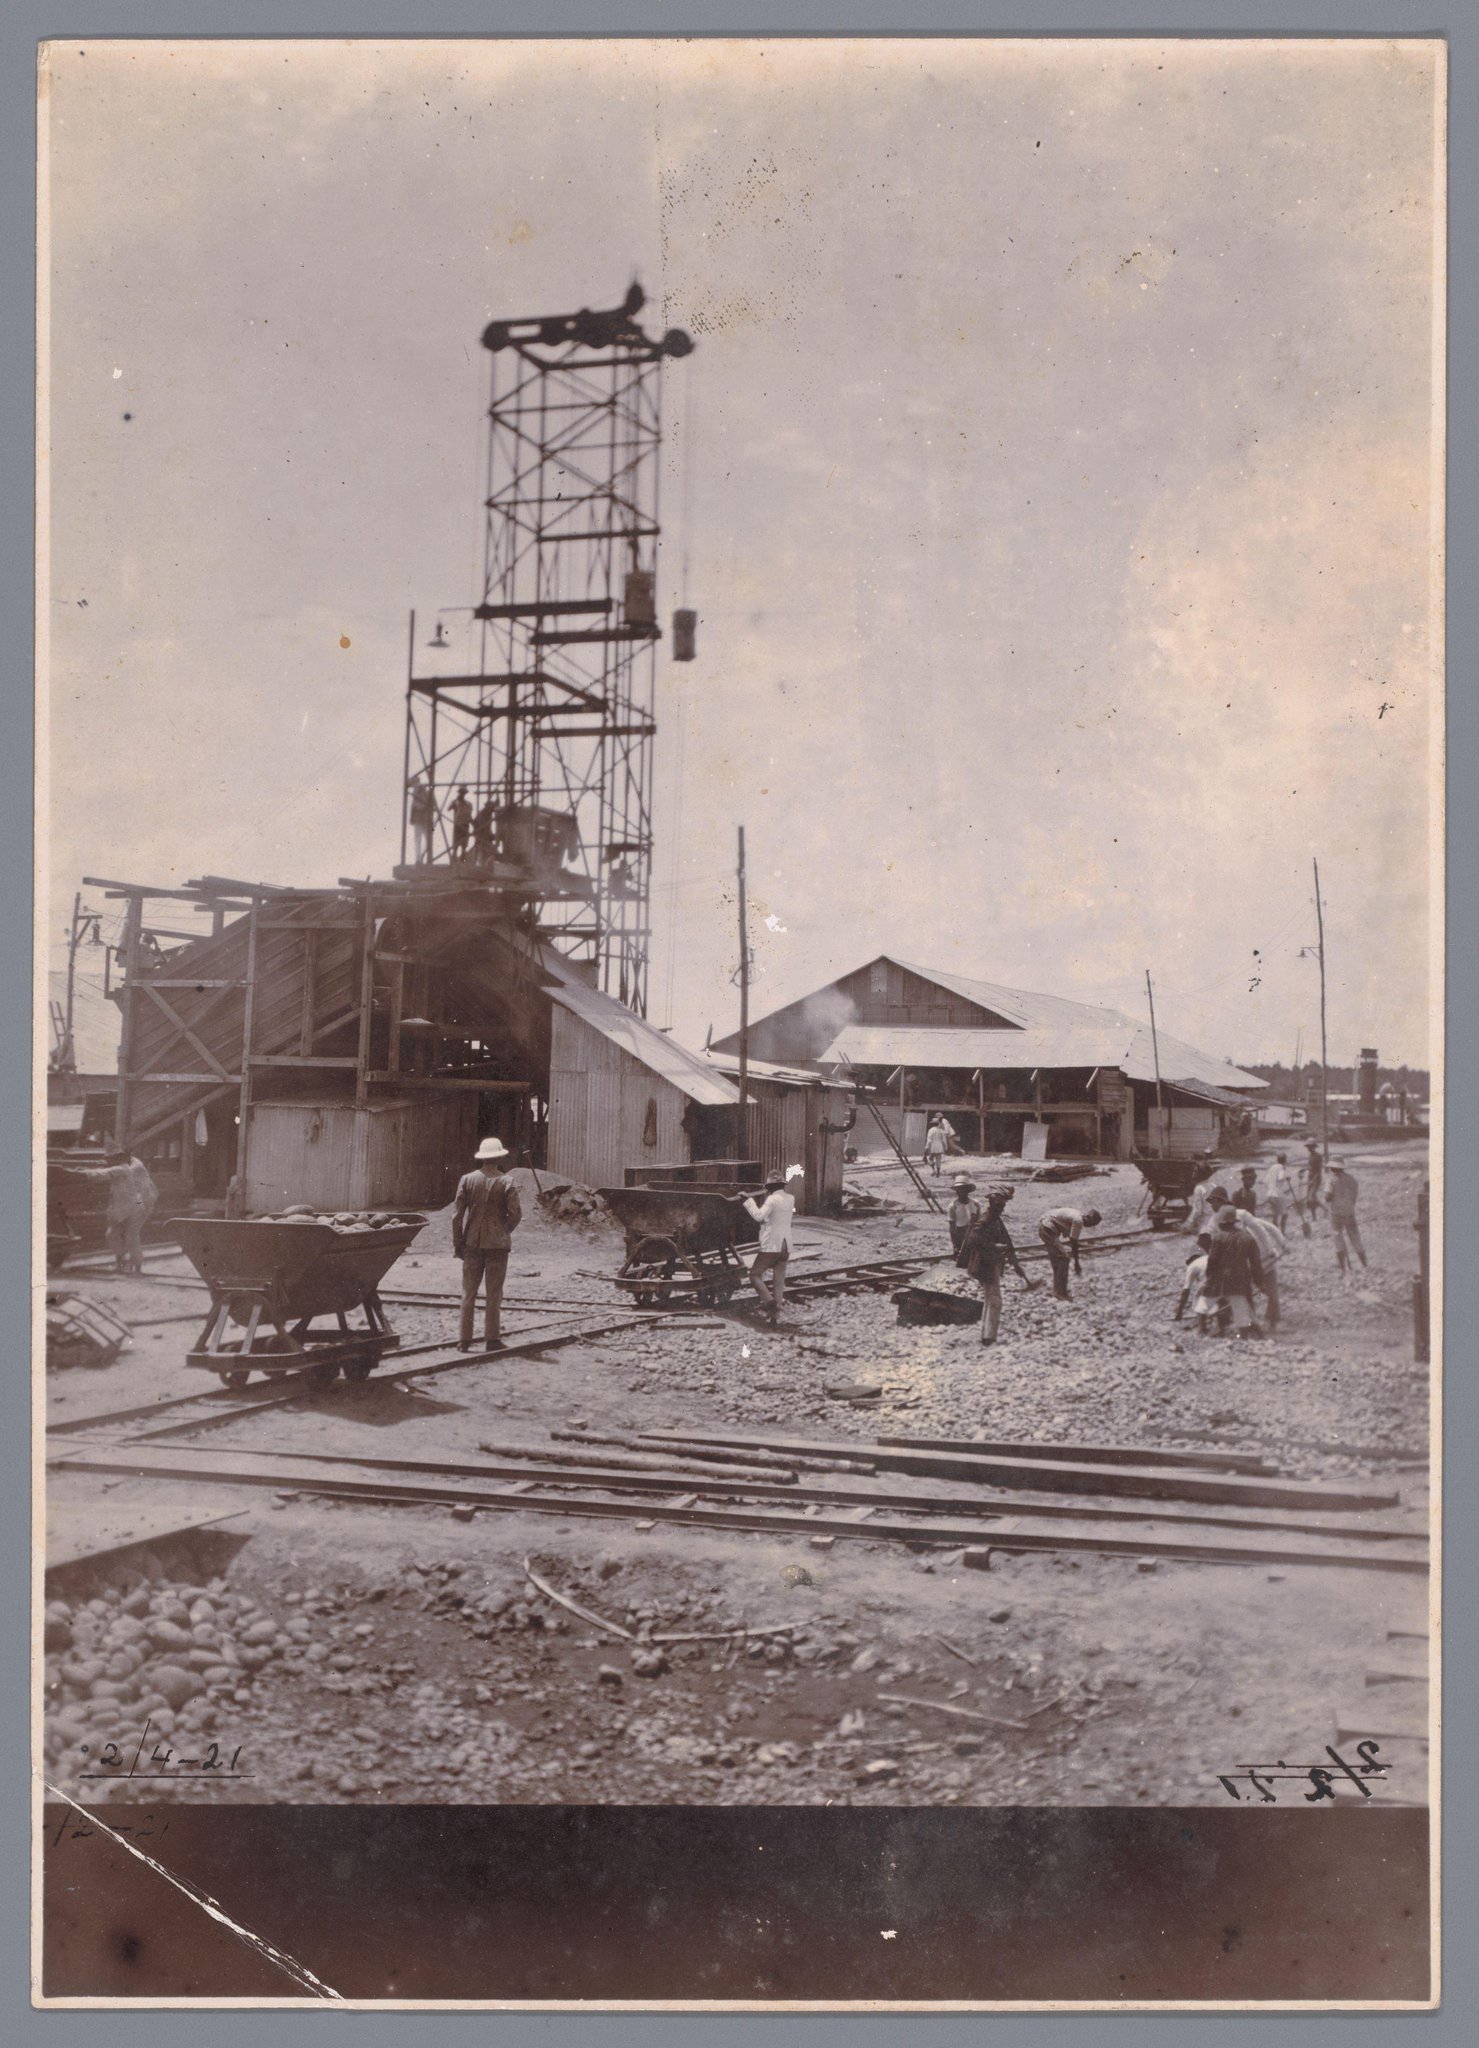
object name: photograph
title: Oceaanhaven Belawan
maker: Anonymous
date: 1921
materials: photographic support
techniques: gelatin silver print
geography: belawan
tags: harbour, building-site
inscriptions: inscription: ‘No. 15. Oceaanhaven Belawan / Lift met grind depot’, date: ‘2/4-21’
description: Bouwterrein met lift en spoorbaan. Genummerd: 15. Onderdeel van de groep van losse foto's over de aanleg van de haven Belawan aan de kust voor Medan, Sumatra 1921-1922.